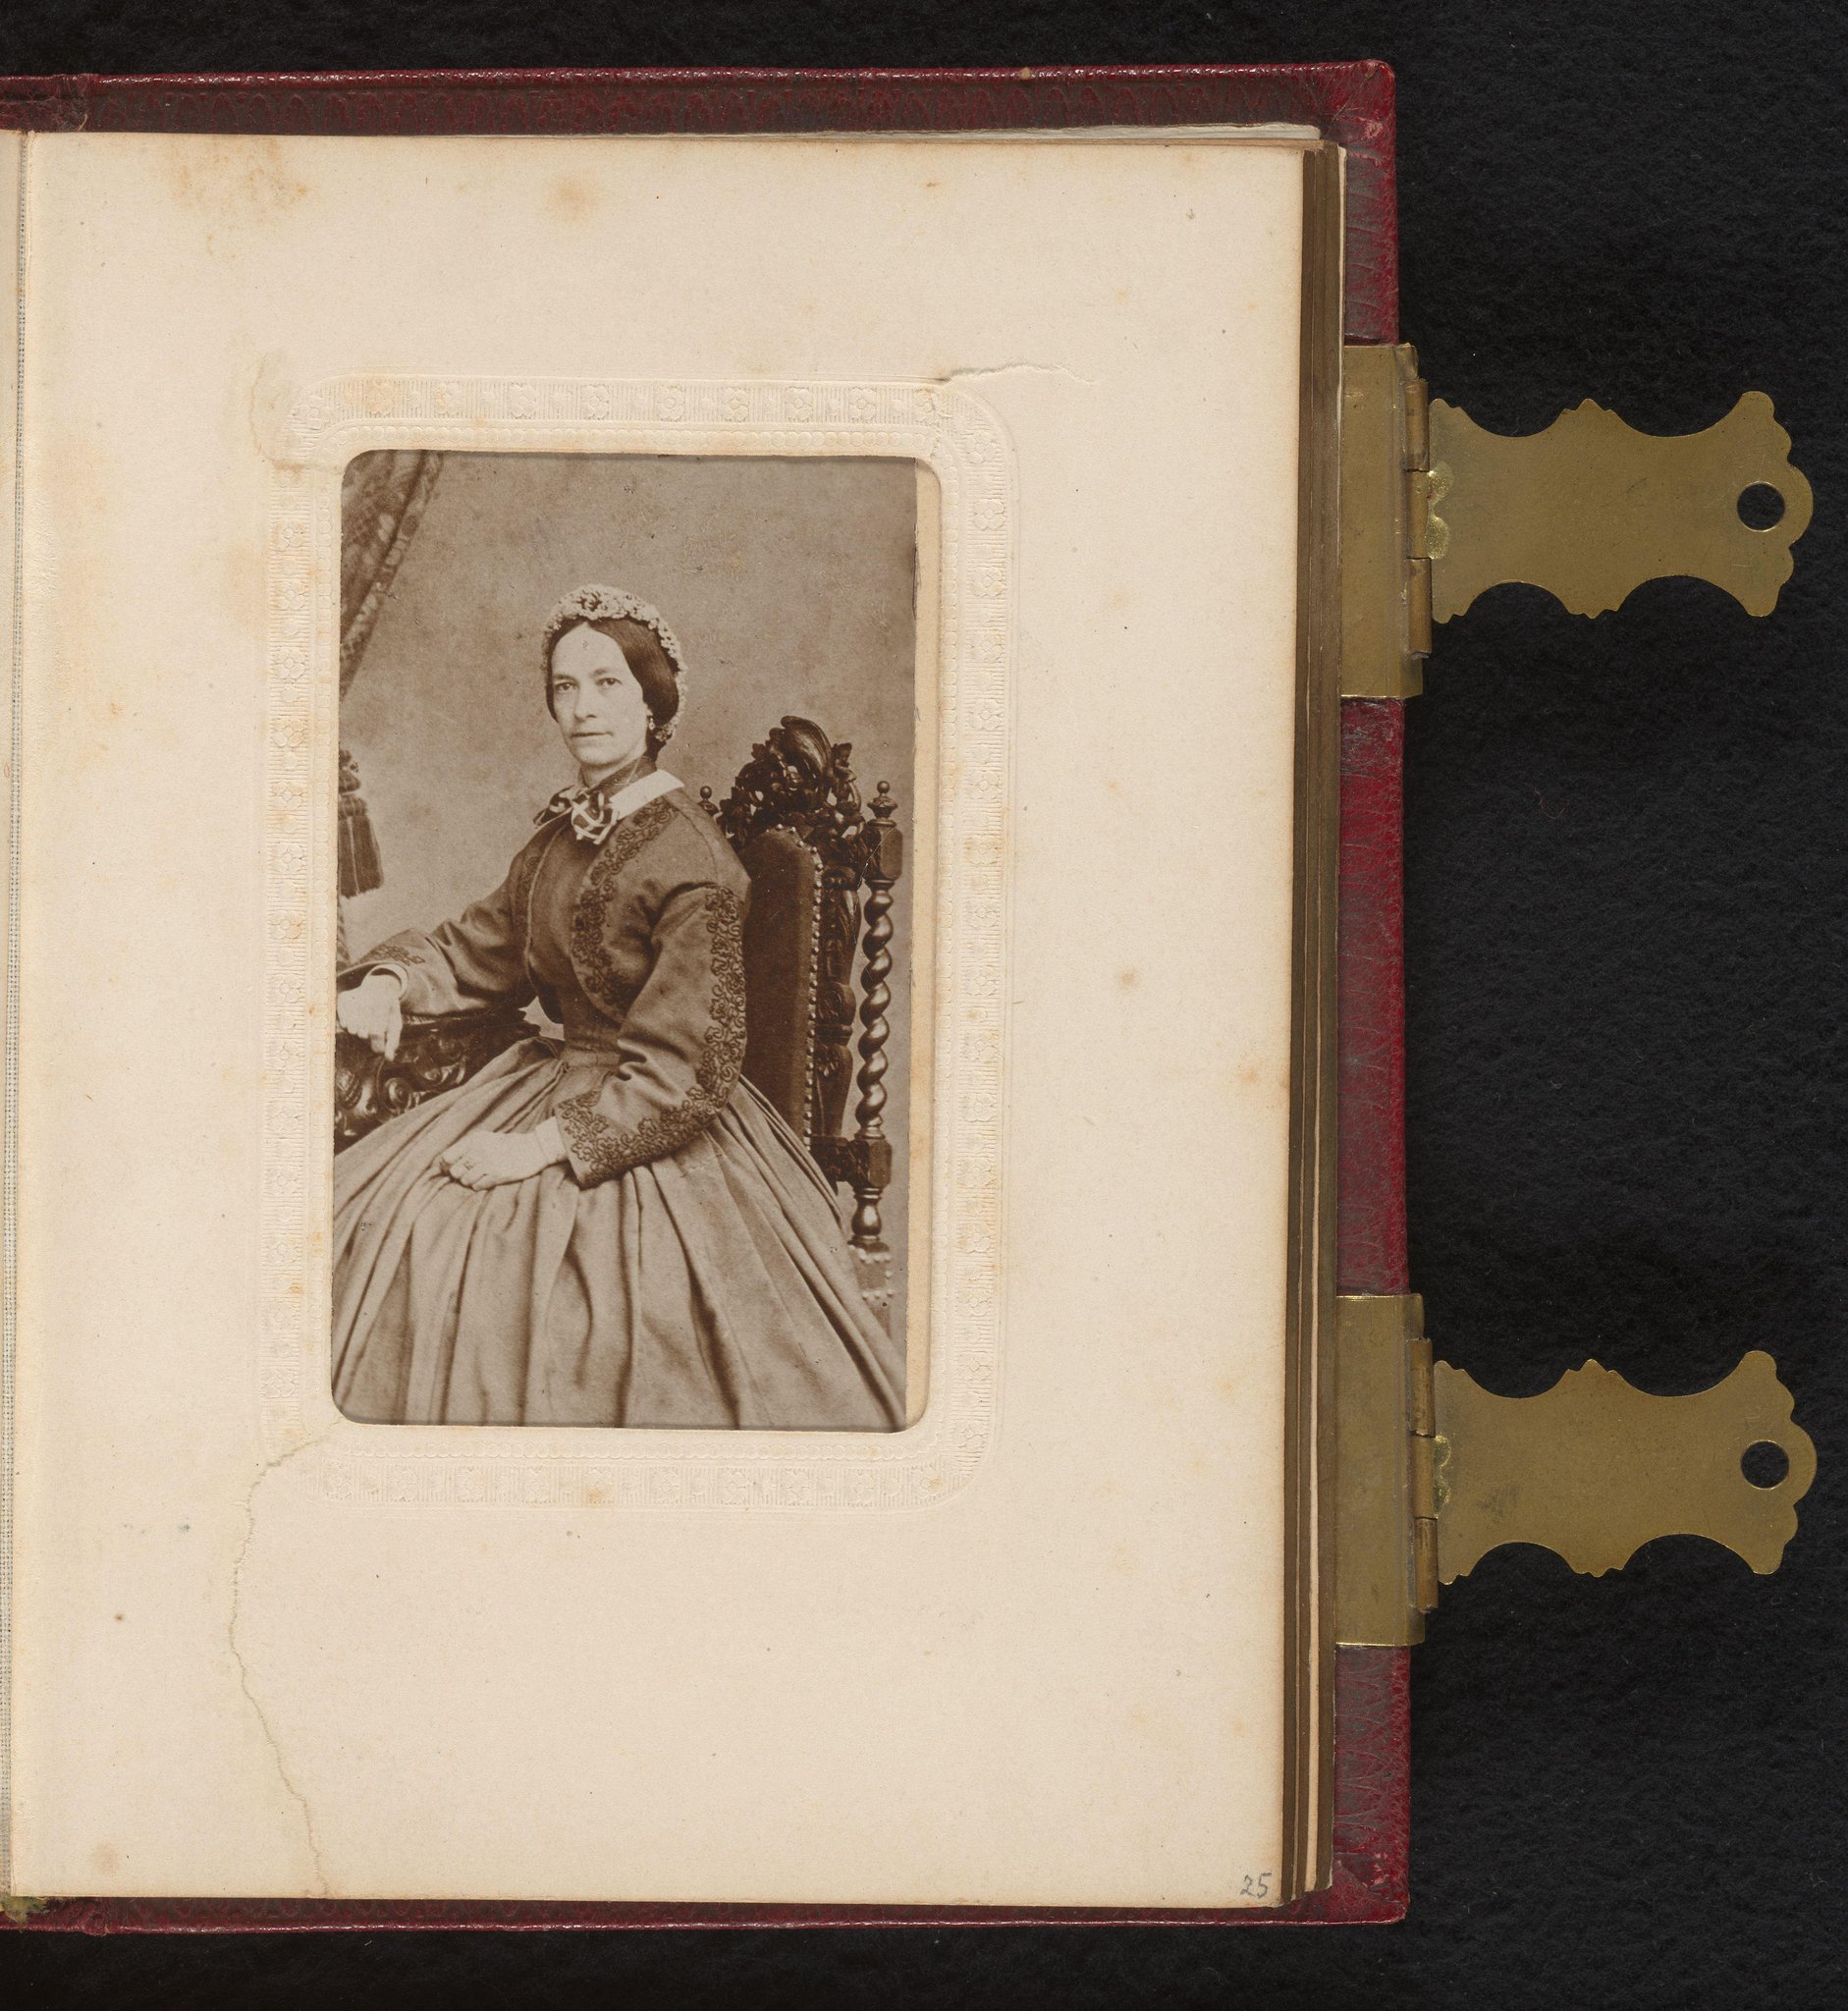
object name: photograph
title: Portret van een zittende vrouw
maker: cornelis johannes lodewicus vermeulen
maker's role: fotograaf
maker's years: 1861-1936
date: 1878-1896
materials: cardboard, photographic support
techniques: collodion silver print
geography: amsterdam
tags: sitting figure - aa - female human figure, historical persons - bb - woman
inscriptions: inscription: ‘C.J.L. VERMEULEN/ Amsterdam/ Heerenstraat 6./ Heiligenweg hoek Singel.’